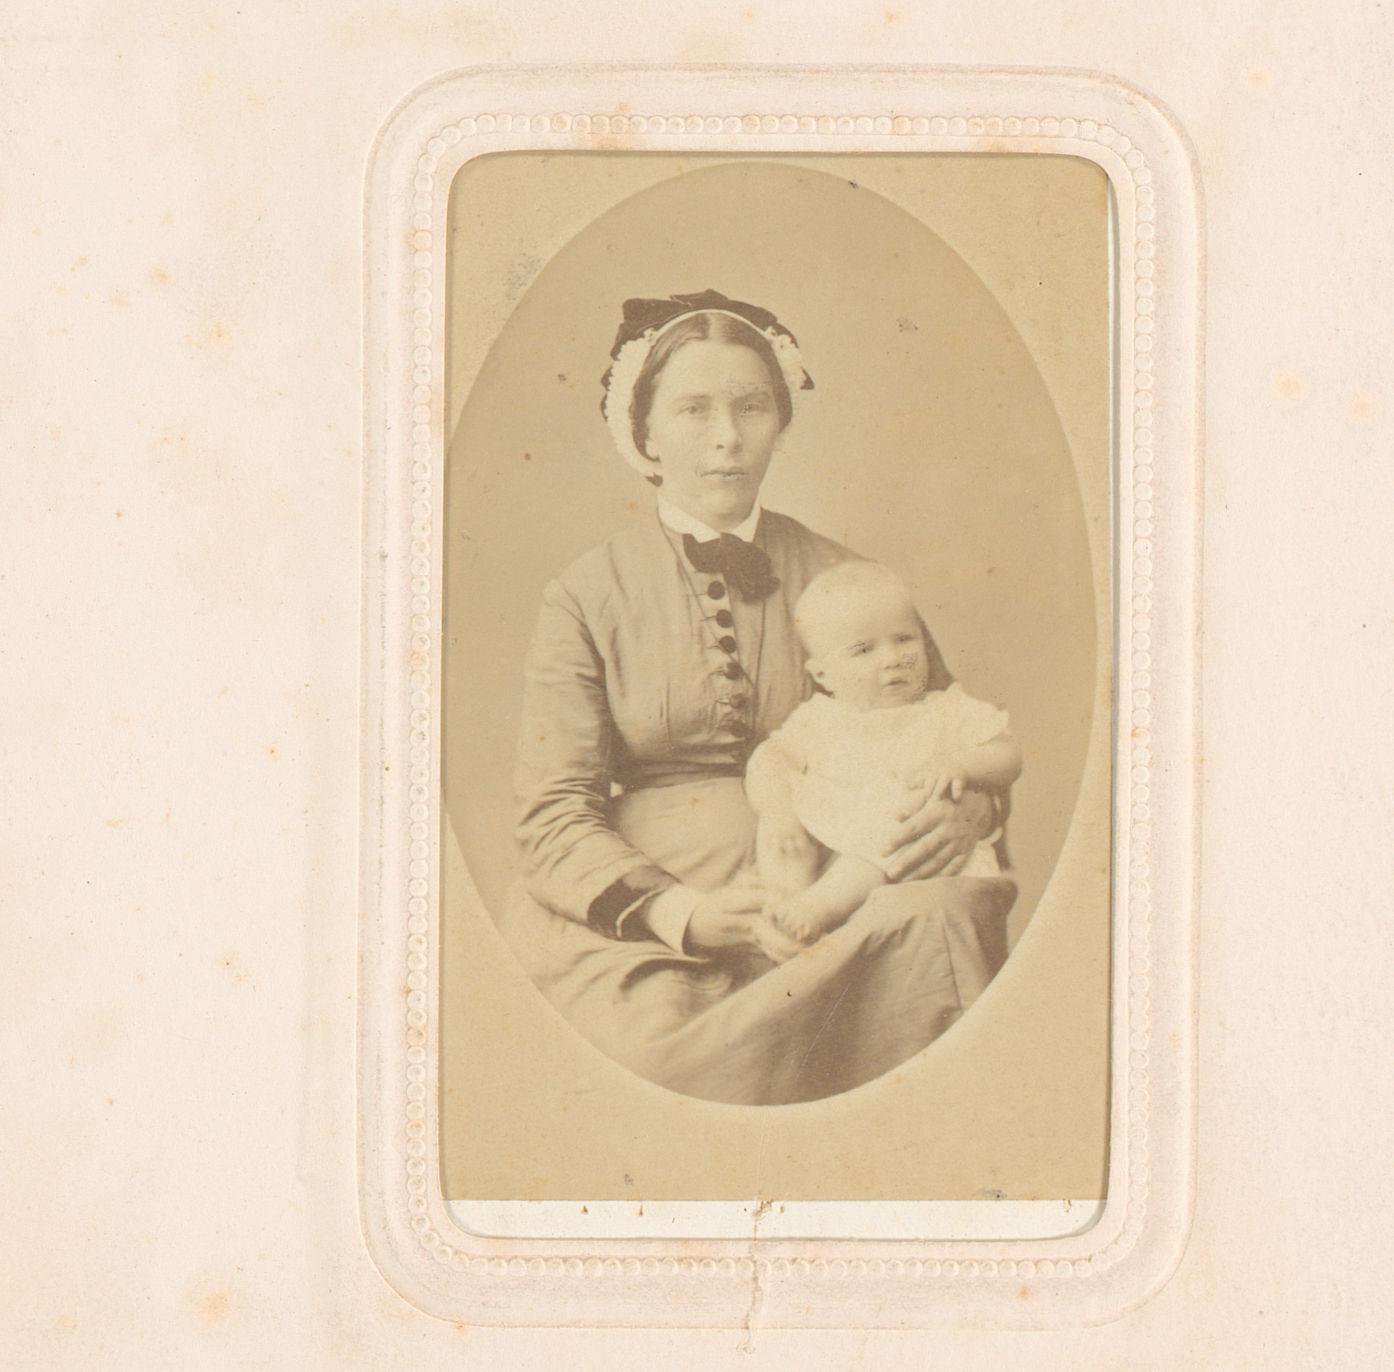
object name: photograph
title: Portret van een zittende vrouw met baby in witte jurk op schoot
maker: georges penabert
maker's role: fotograaf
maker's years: 1825-1903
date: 1860-1890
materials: cardboard, photographic support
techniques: albumen print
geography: paris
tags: sitting figure - aa - female human figure, historical persons - bb - woman, infant, baby ~ the ages of man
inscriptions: inscription: ‘G. Penabert/ Passage du Hâvre 36 & 38./ Au Rez-de-Chaussée/ PARIS’